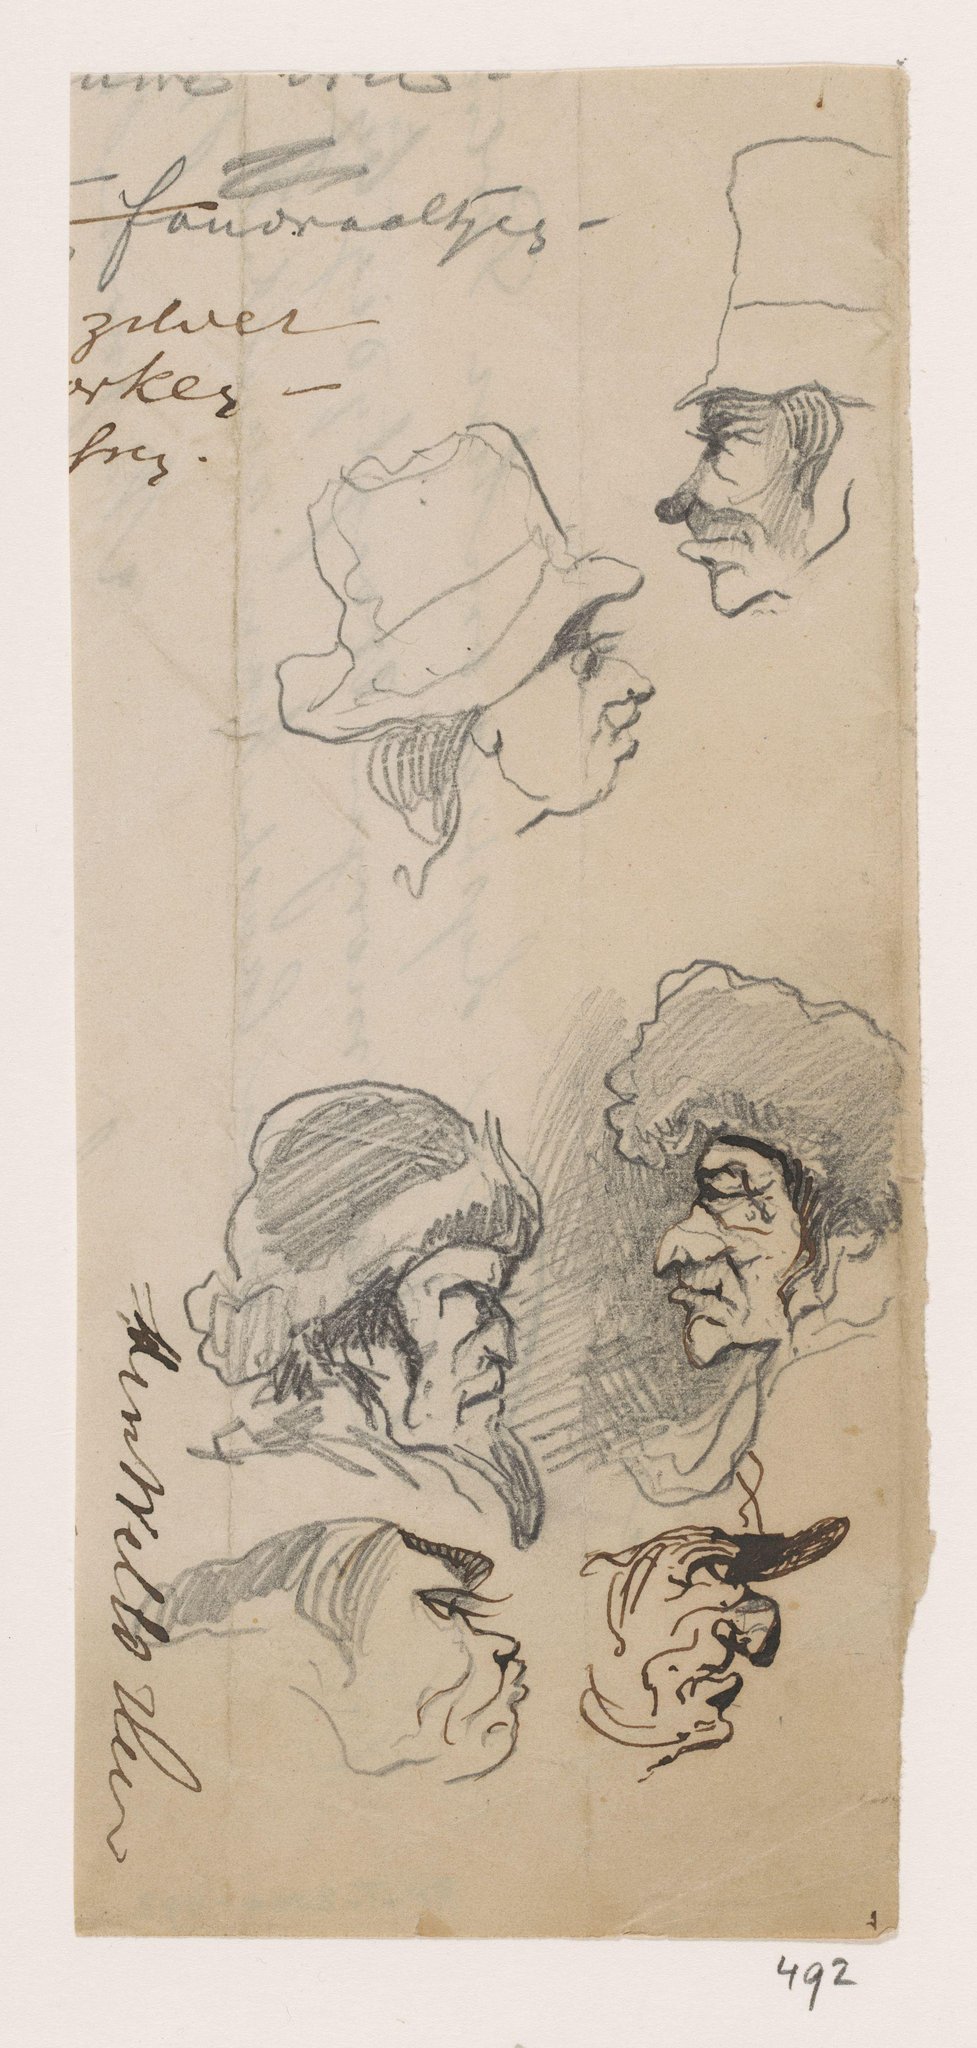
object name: drawing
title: Koppen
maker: johannes tavenraat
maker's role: draughtsman, painter, print maker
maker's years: 1809-1881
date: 1840-1880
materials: ink, paper, pencil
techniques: pen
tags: caricatures (human types)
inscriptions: collector's mark: Lugt 2228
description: Koppen, met op voor- en achterzijde verschillende notities.